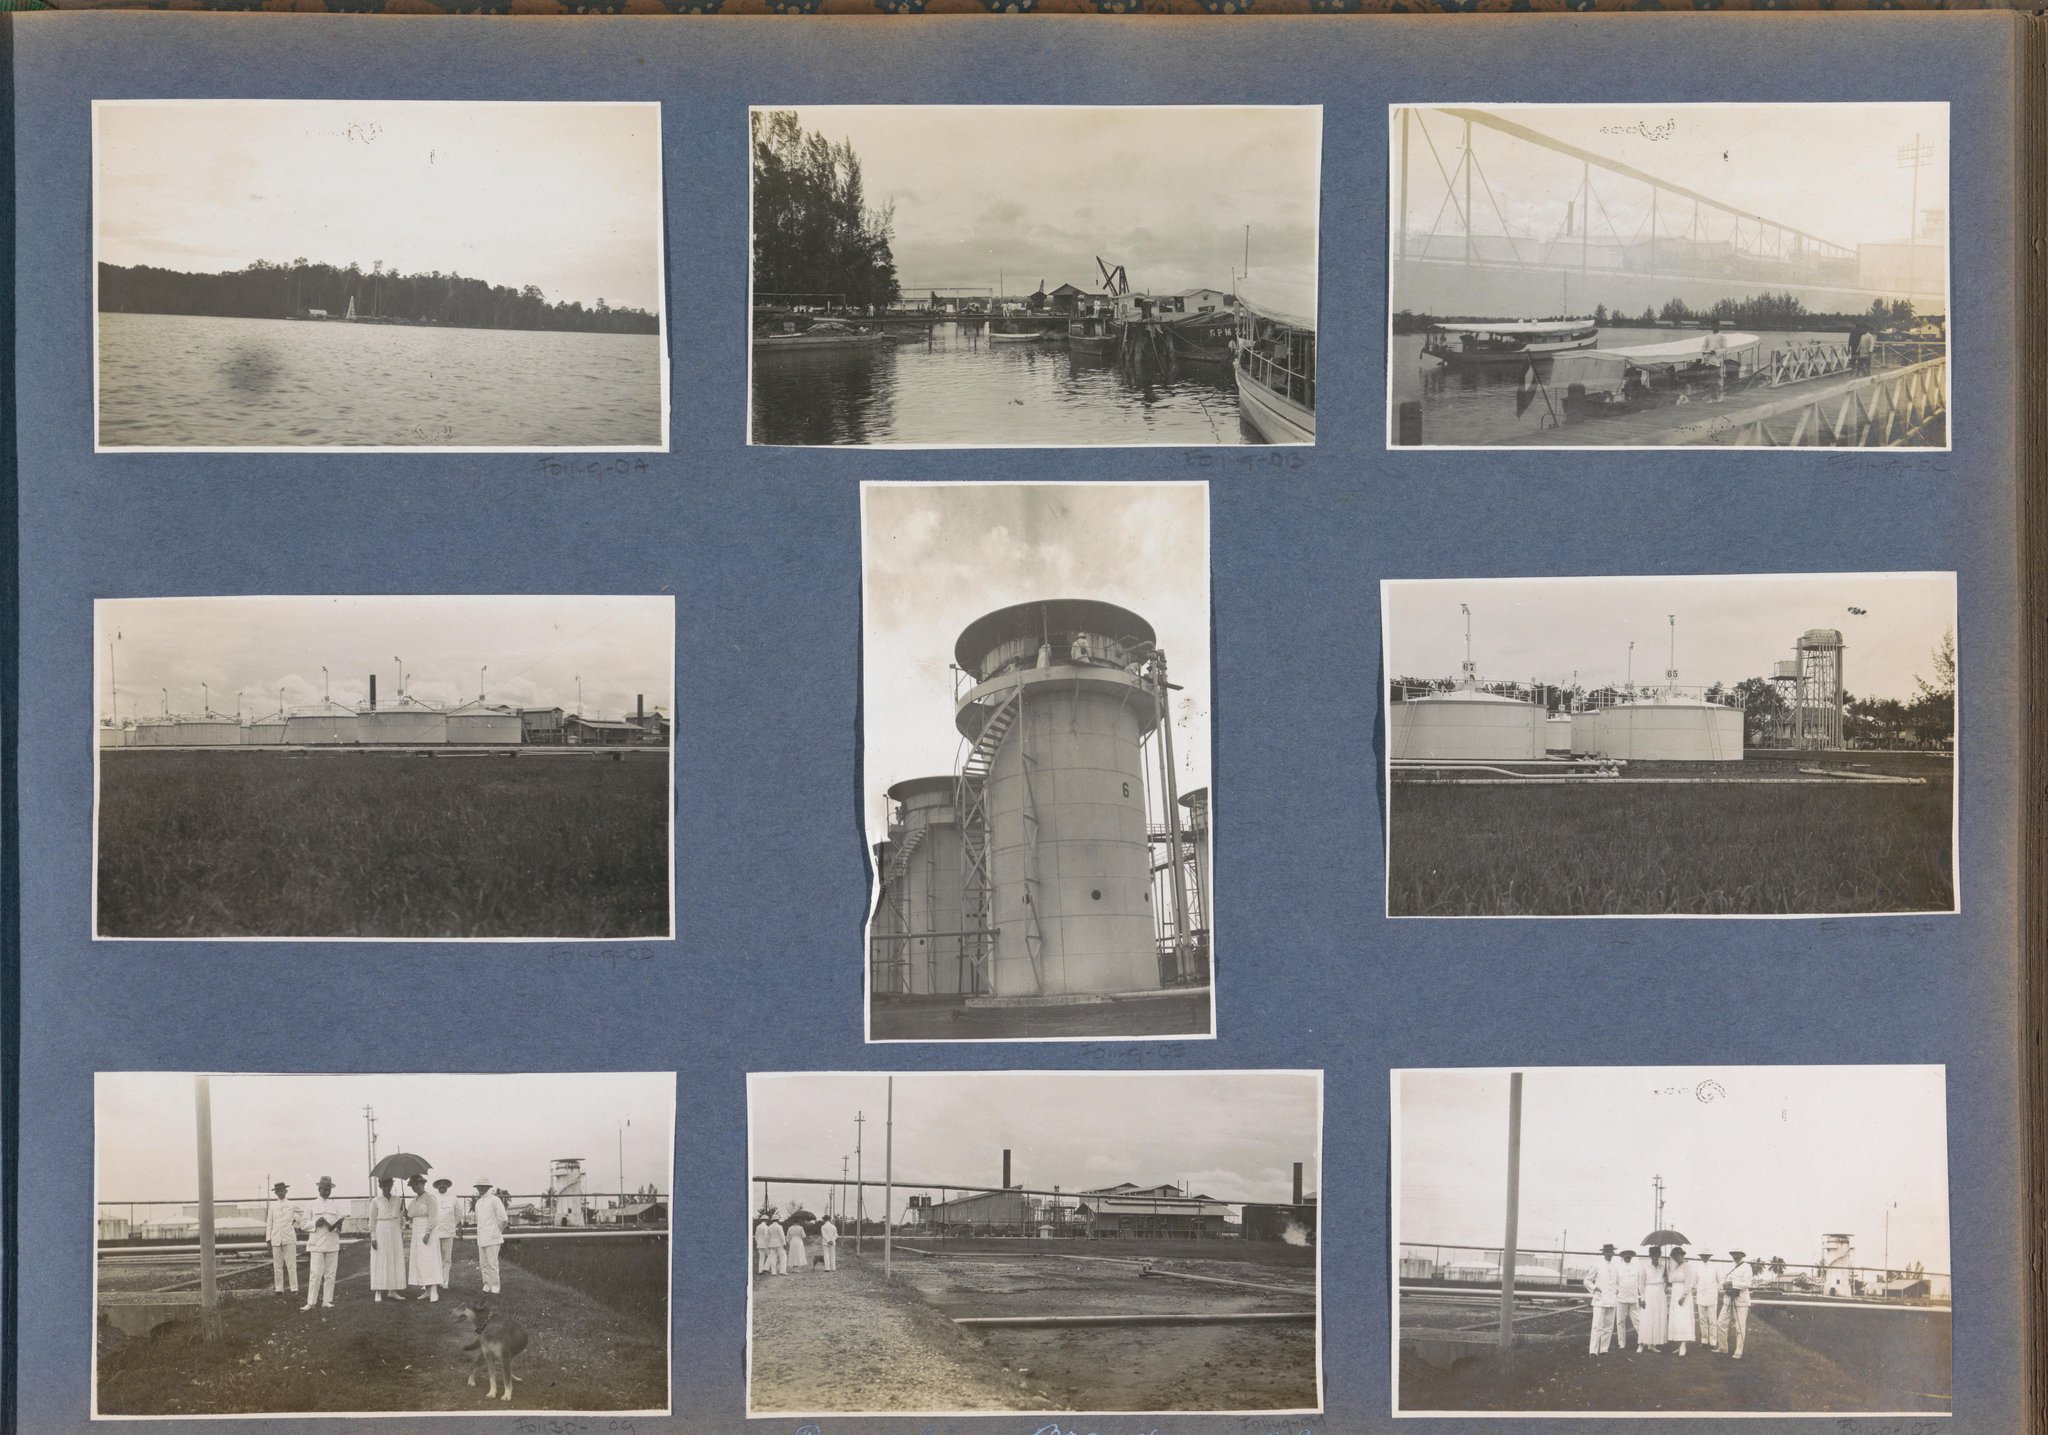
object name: photograph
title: Boten op een water te Pangkalan-Brandan op Sumatra, op de achtergrond Europeanen op een brug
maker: Anonymous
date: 1900-1920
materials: paper, photographic support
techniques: gelatin silver print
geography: sumatra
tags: harbour (+ view ~ vehicle, ship, etc.), sumatra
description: Onderdeel van reisalbum met foto's van bedrijvigheid en bezienswaardigheden op Sumatra en Java en van de reis naar en van Nederlands-Indië.